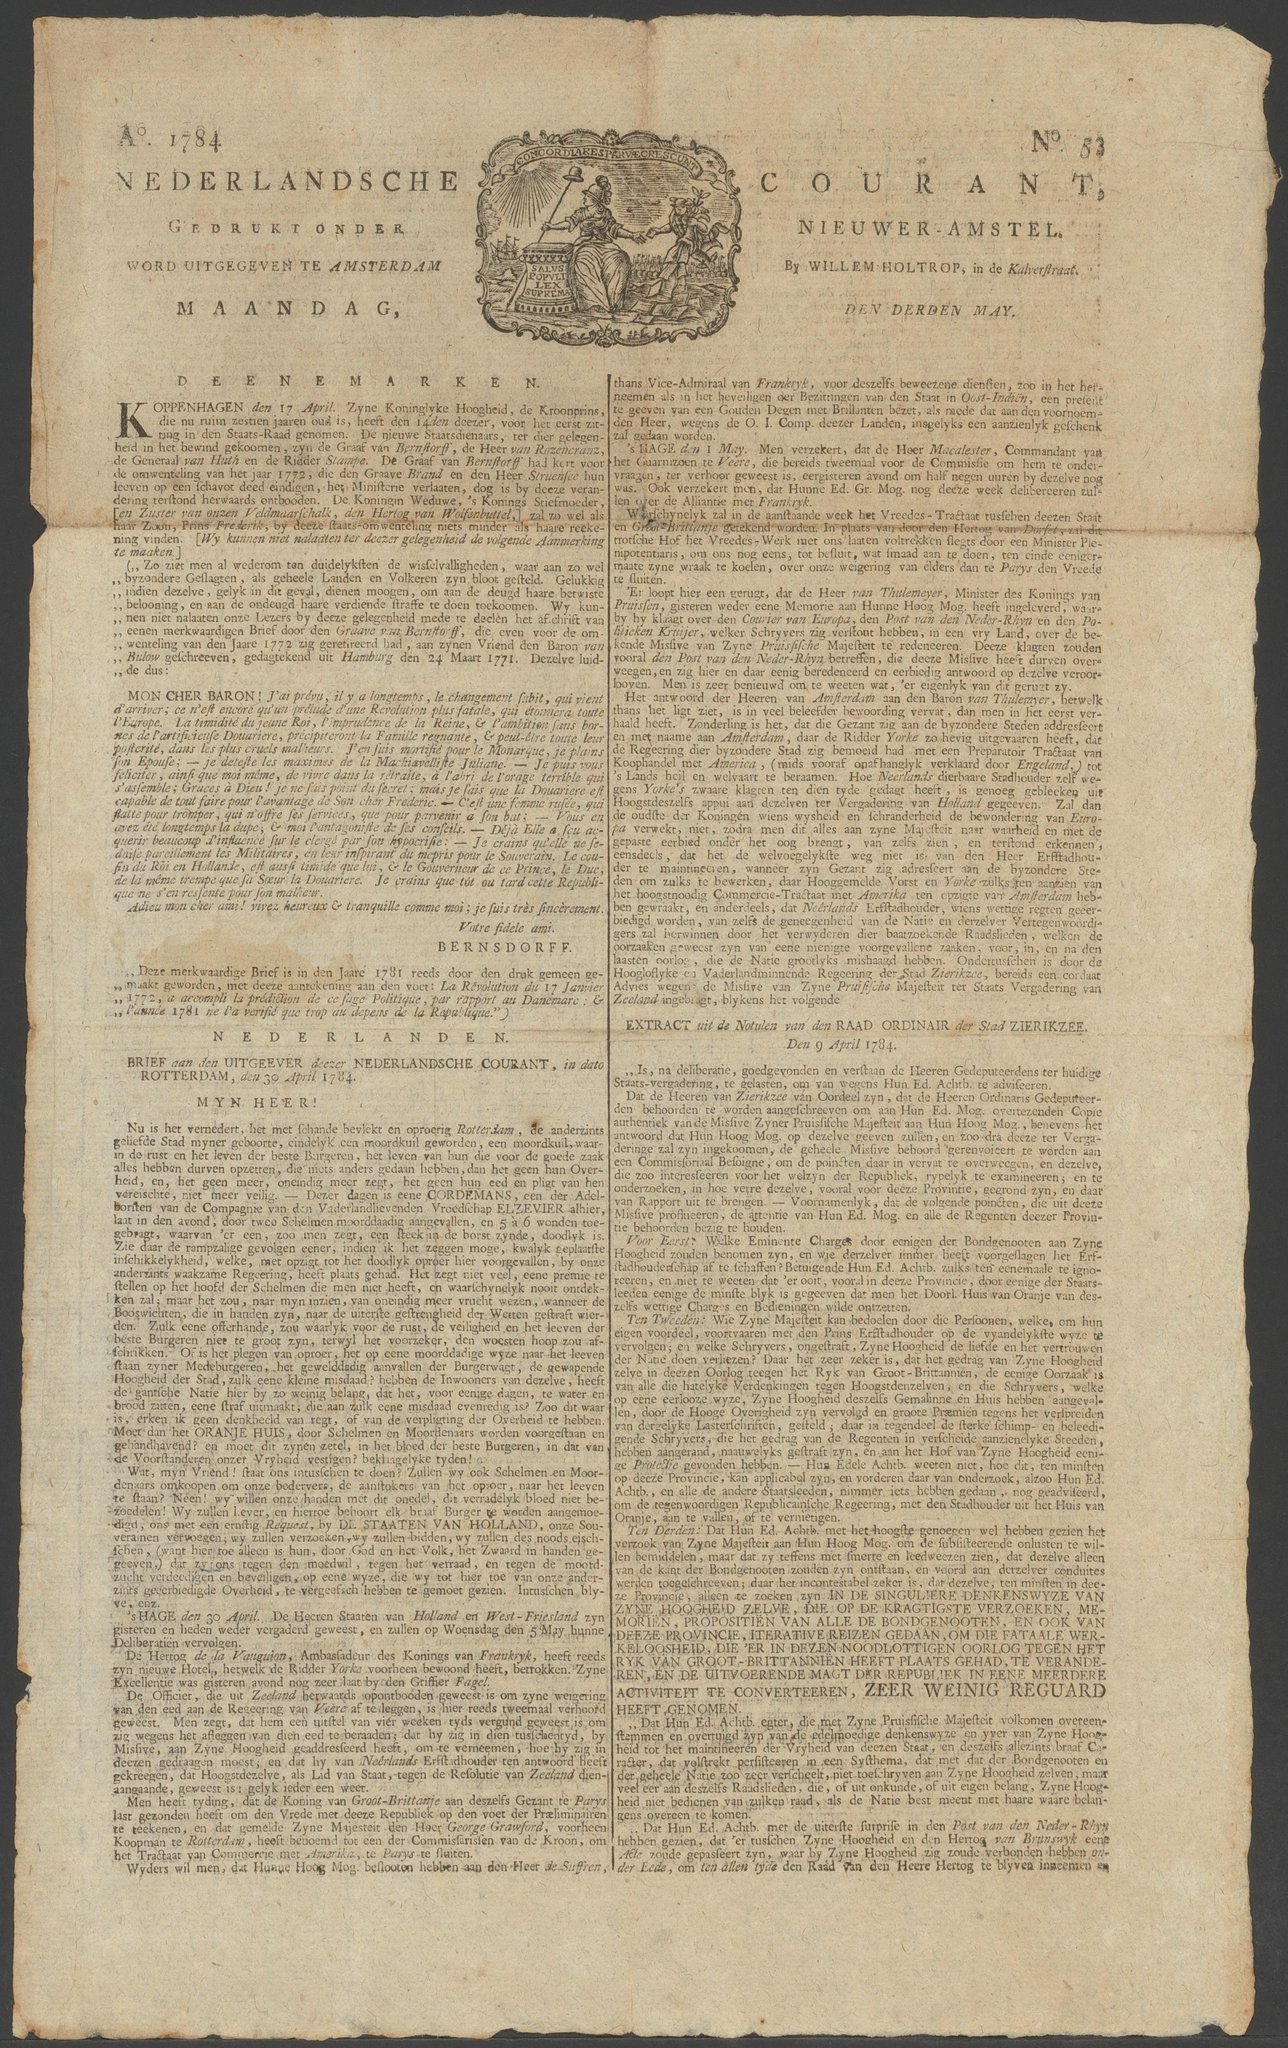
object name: newspaper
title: Nederlandsche Courant, 3 mei 1784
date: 1784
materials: paper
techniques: letterpress printing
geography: nieuwer-amstel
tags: newspaper, news-sheet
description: Exemplaar van de krant 'Nederlandsche Courant' van 3 mei 1784. Enkelbladig, beide zijden bedrukt. Bovenaan een vignet met de Vrijheid en Mercurius. Onderwerpsrubrieken binnen de Atlas Zeden en Gewoonten: Regeering, Officieele Nieuwsbladen.